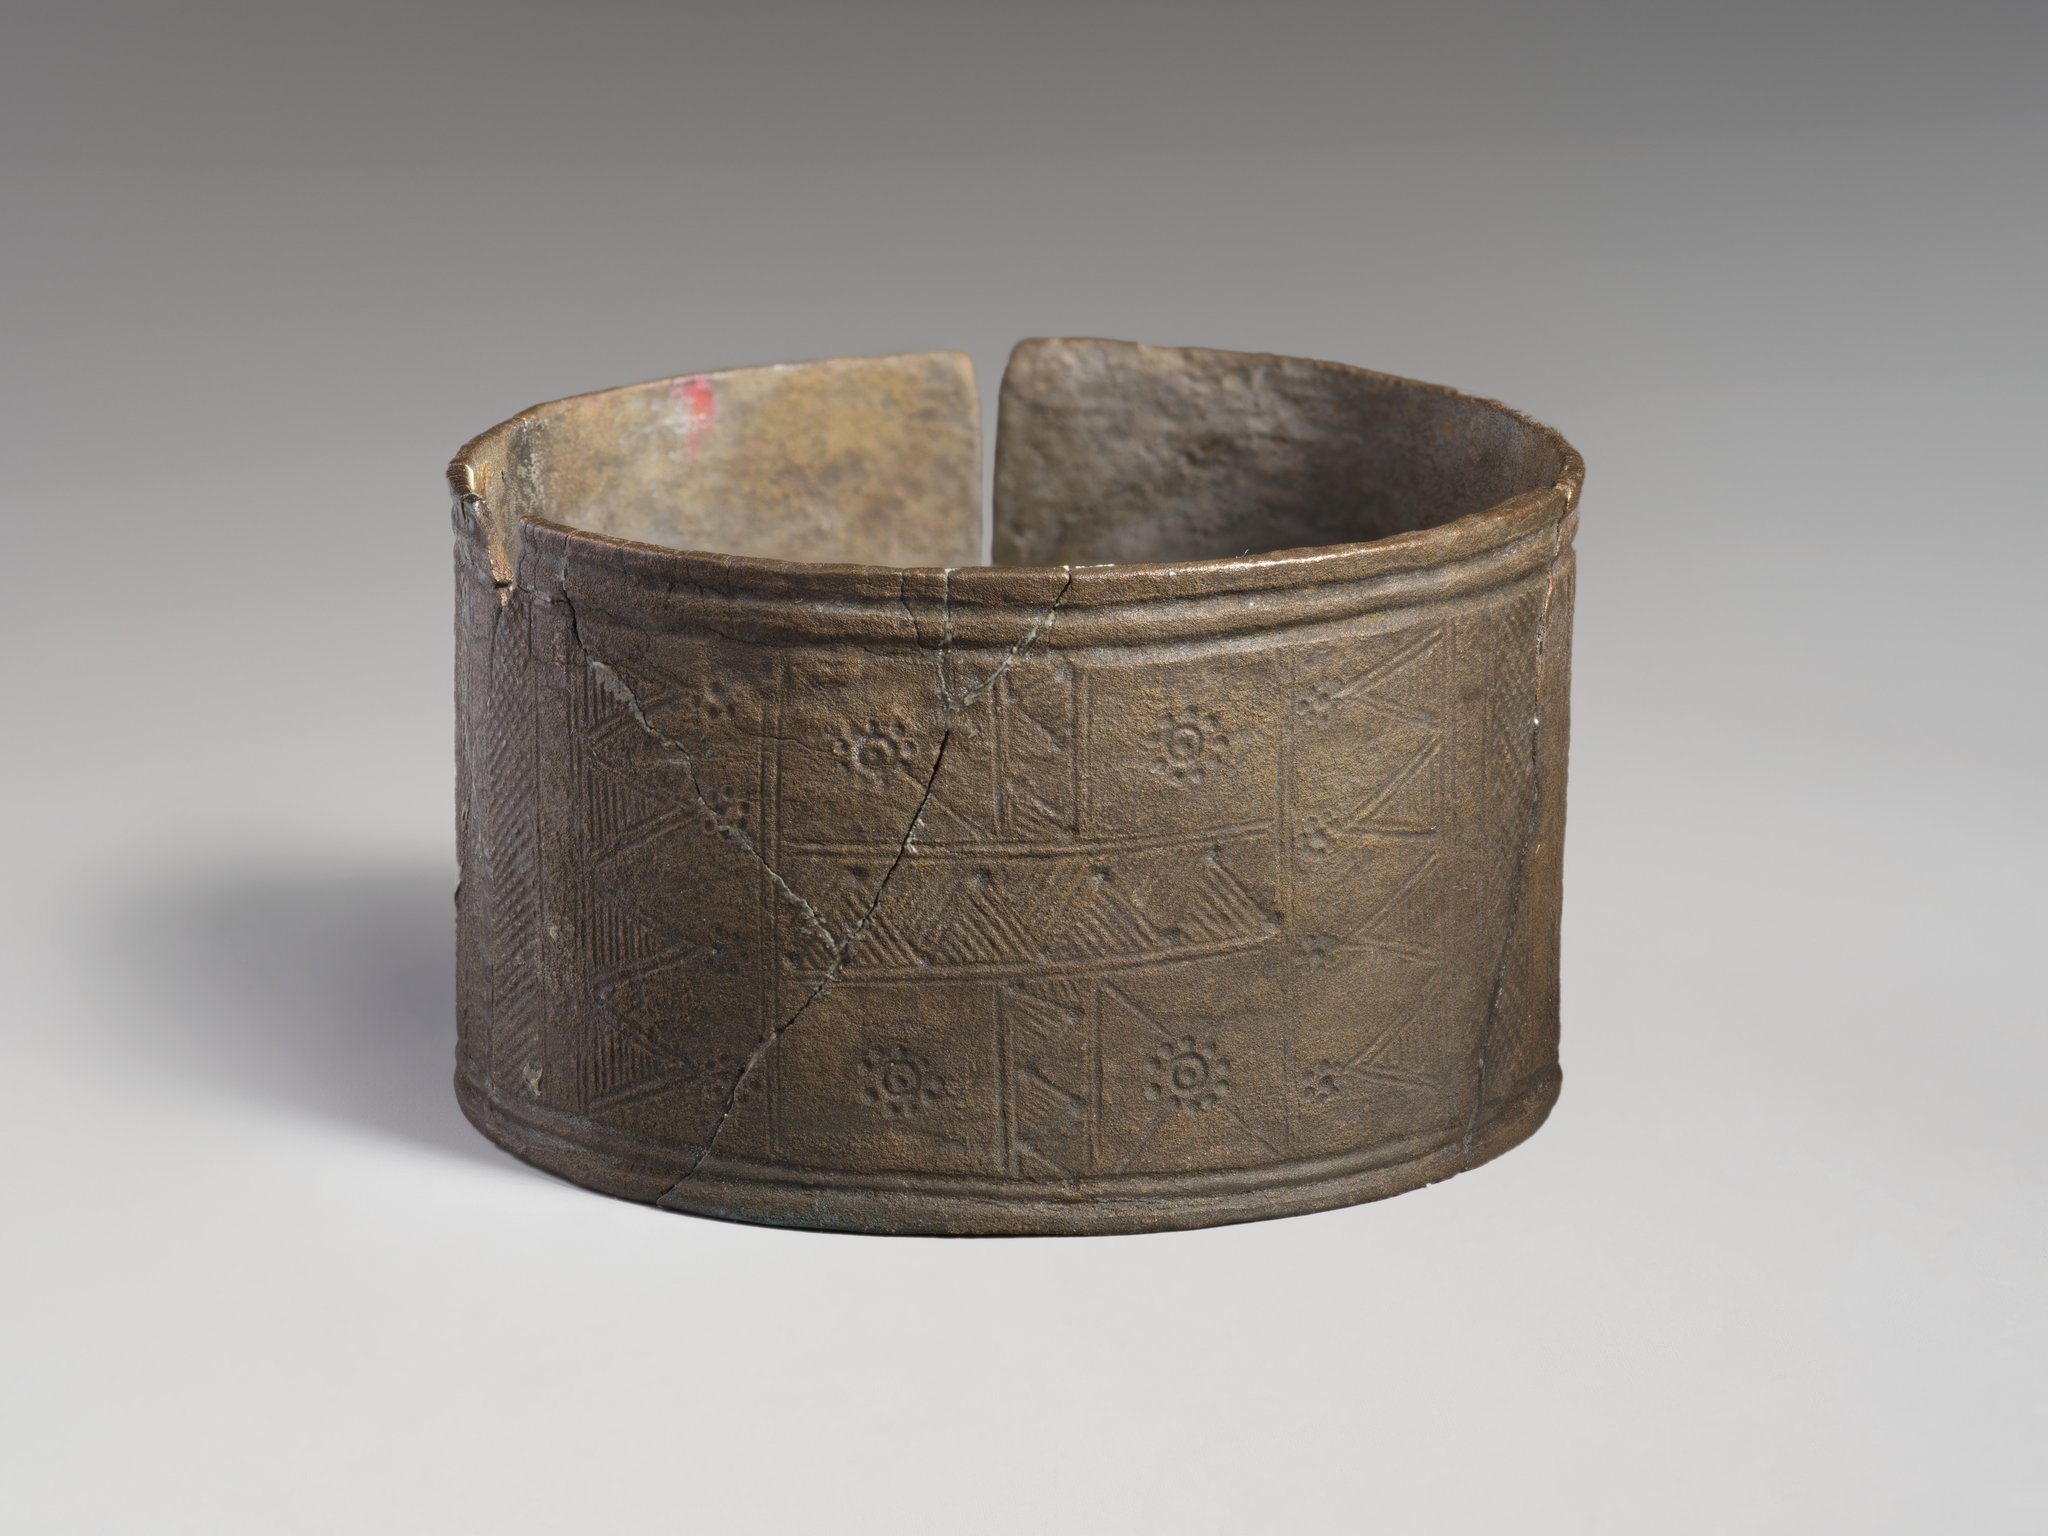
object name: bracelet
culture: iranian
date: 900-801 BCE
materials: bronze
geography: iran